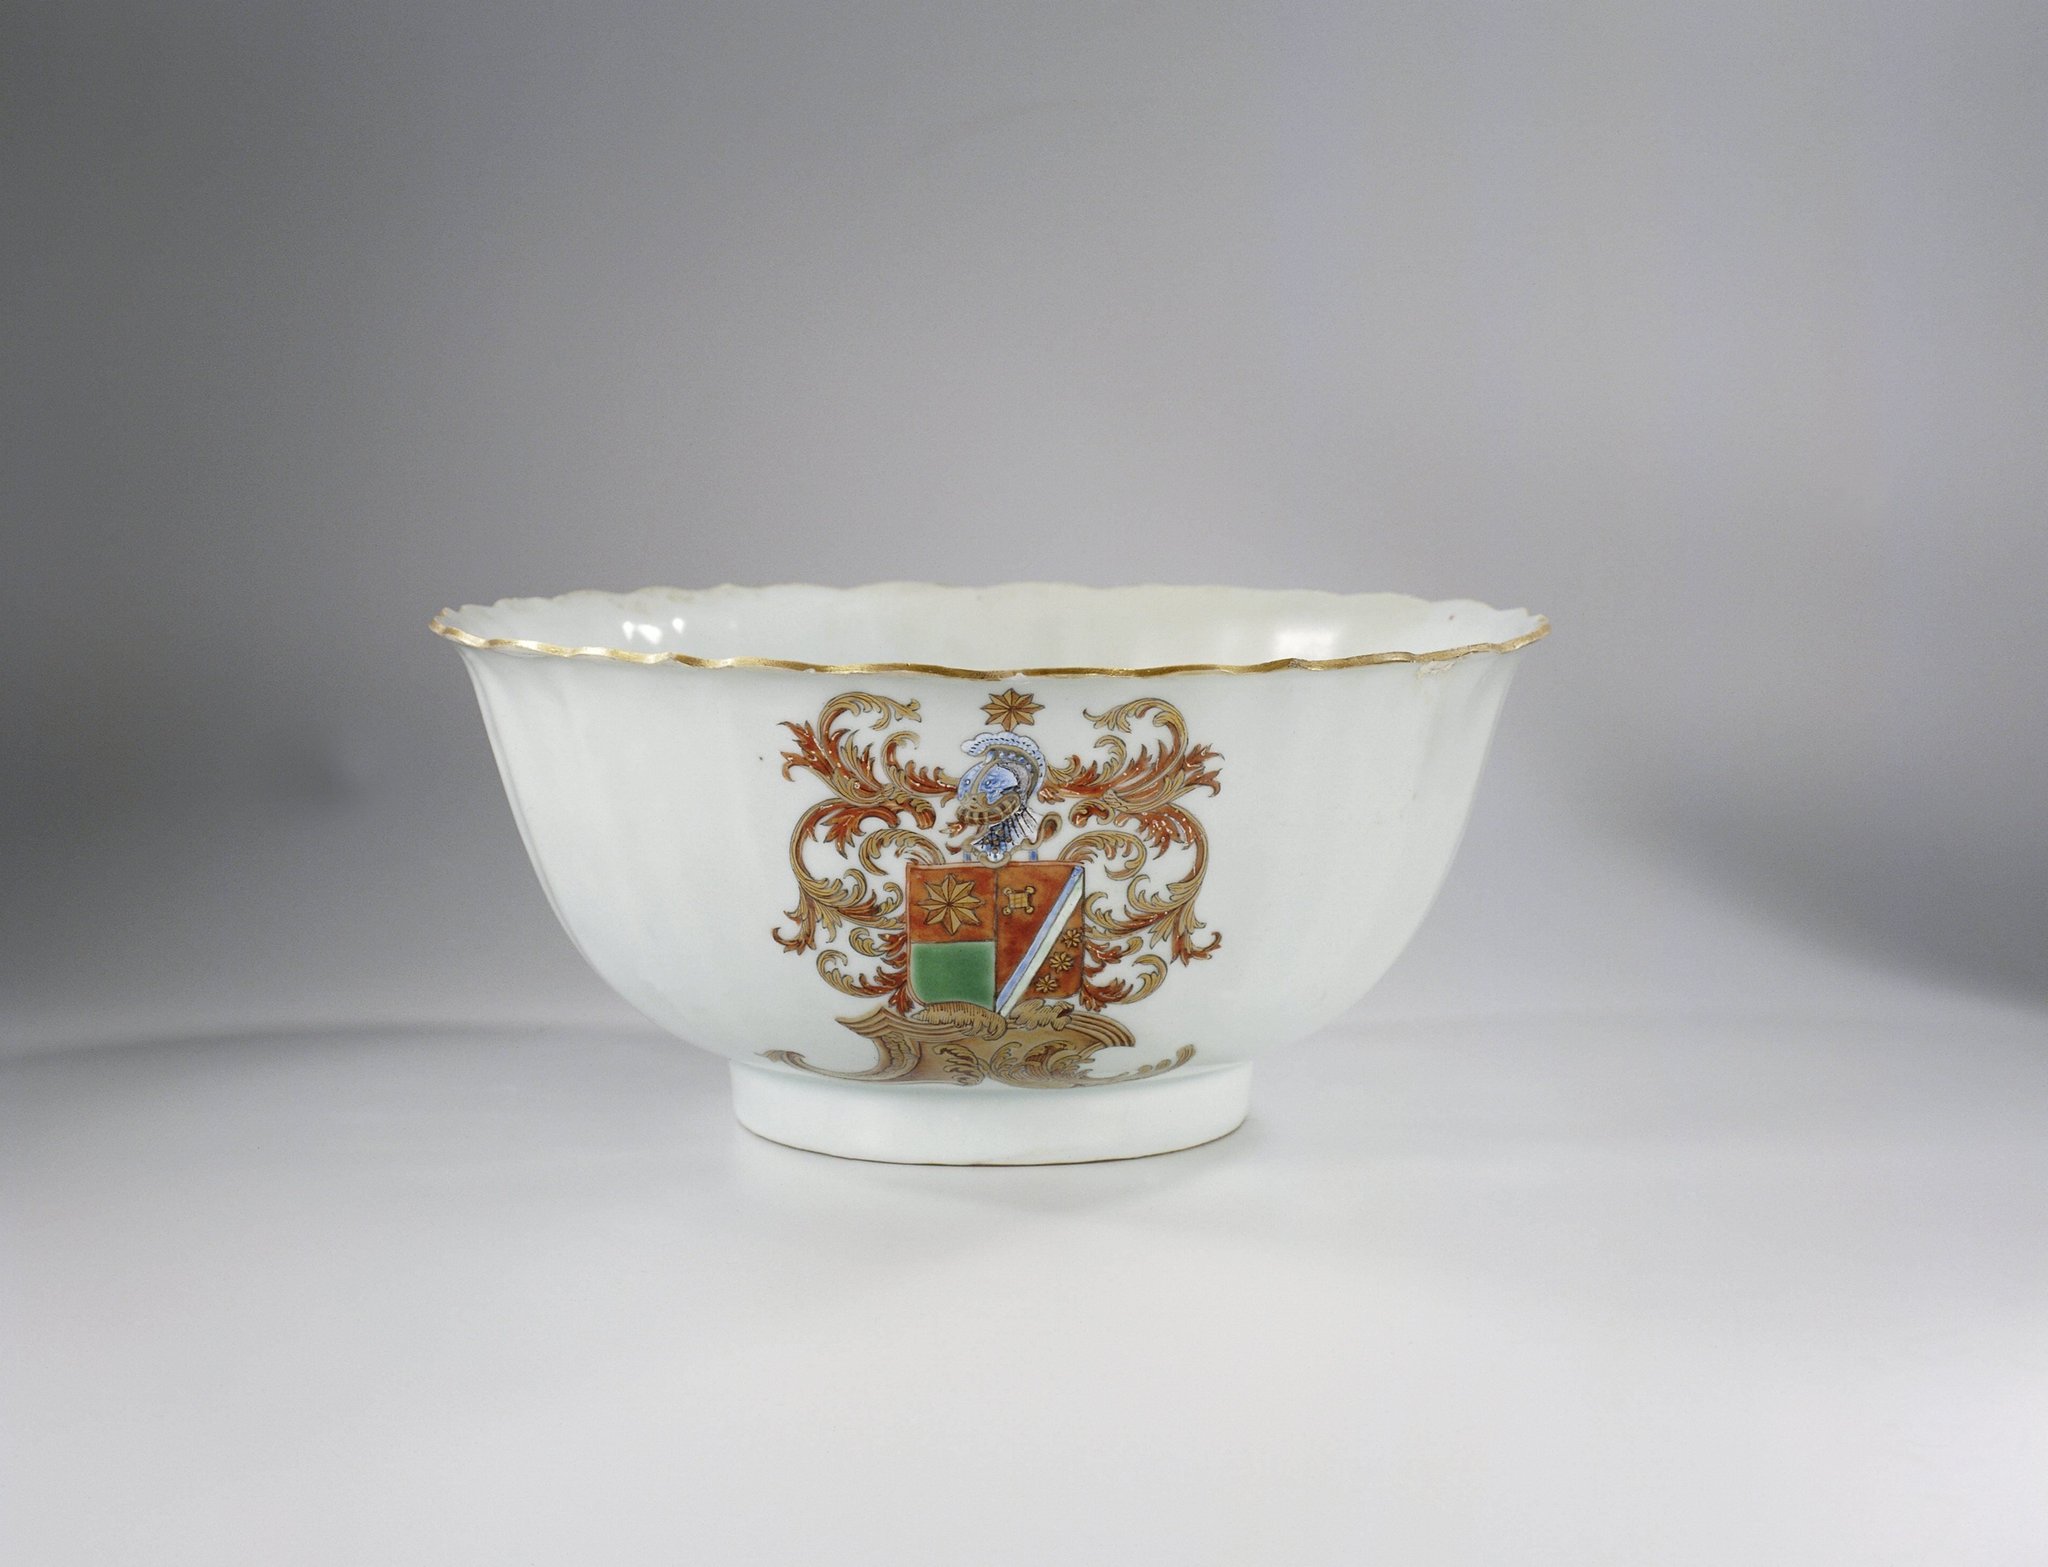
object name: bowl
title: Bowl with the arms of the De Heere van Holy family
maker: Anonymous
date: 1760-1765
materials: glaze, gold, paint, porcelain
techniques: firing, gilding, turning, vitrification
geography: china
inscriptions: label: ‘Pieter de Heere van Holy’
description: Kom van porselein met geribde wand en geschulpte rand, beschilderd op het glazuur in blauw, rood, groen, zwart en goud. Op de buitenwand tweemaal het wapen van de familie De Heere van Holy. Het helmteken is een ster en het wapen is omgeven door bladranken. Oud label op de onderzijde met 'Pieter de Heere van Holy'. Wapenporselein met emailkleuren.